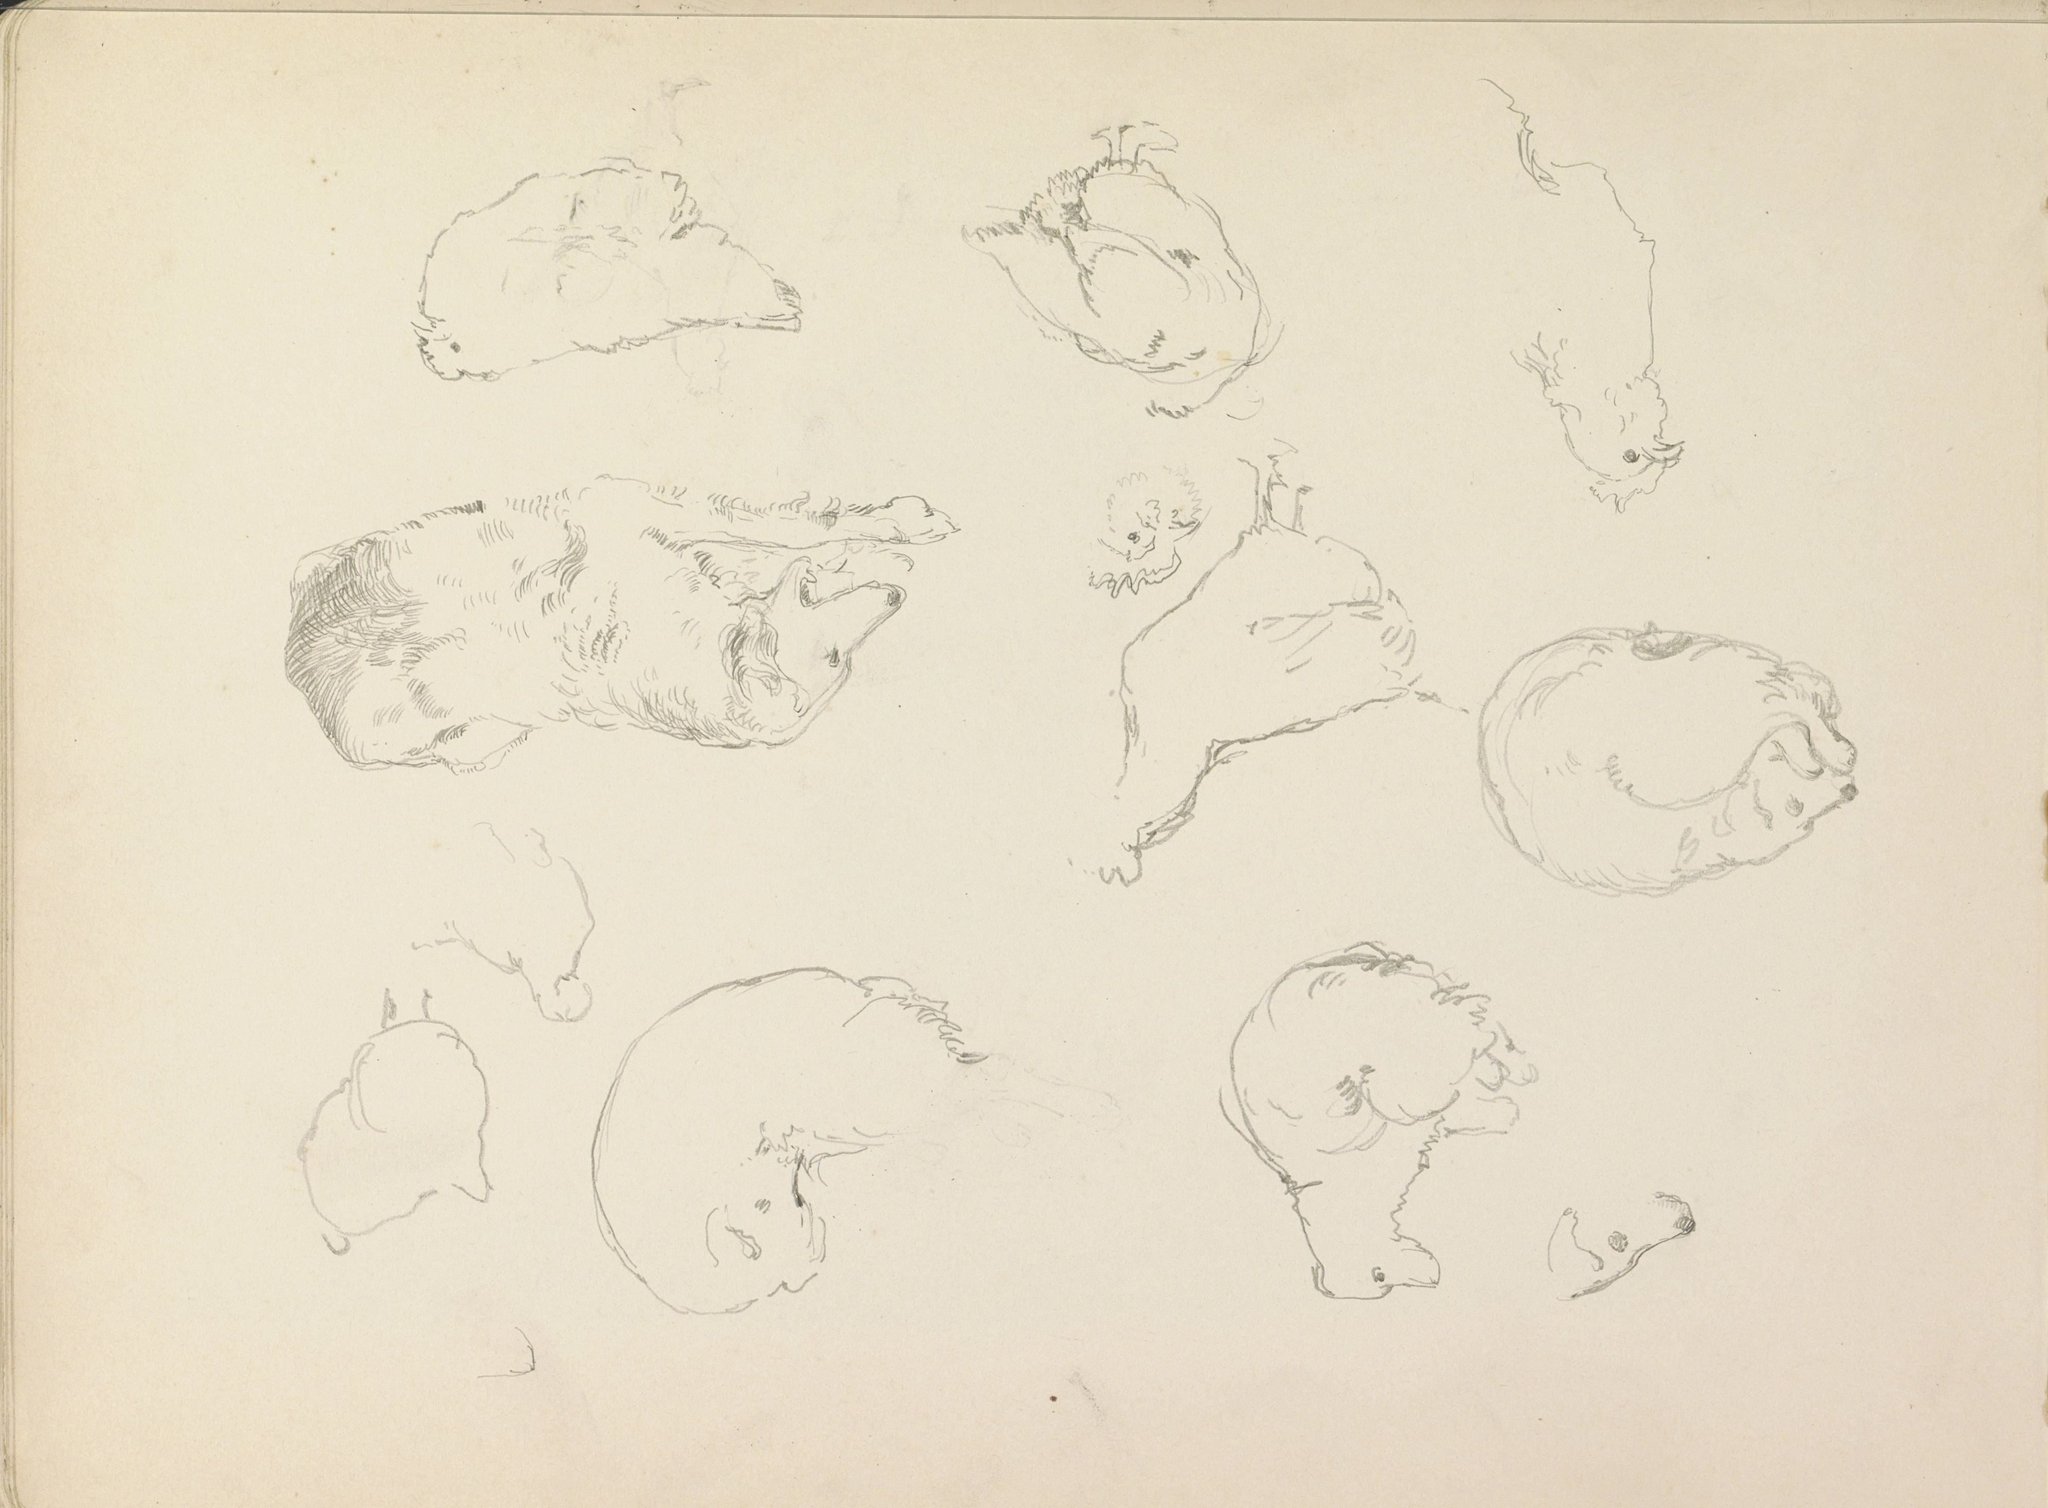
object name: sketchbook leaf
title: Kippen en liggende honden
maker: cornelis vreedenburgh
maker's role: draughtsman, print maker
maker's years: 1880-1946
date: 1890-1946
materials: paper, pencil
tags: fowl (cock, hen, chicken, etc.), dog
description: Blad 16 verso uit een schetsboek met 23 bladen.